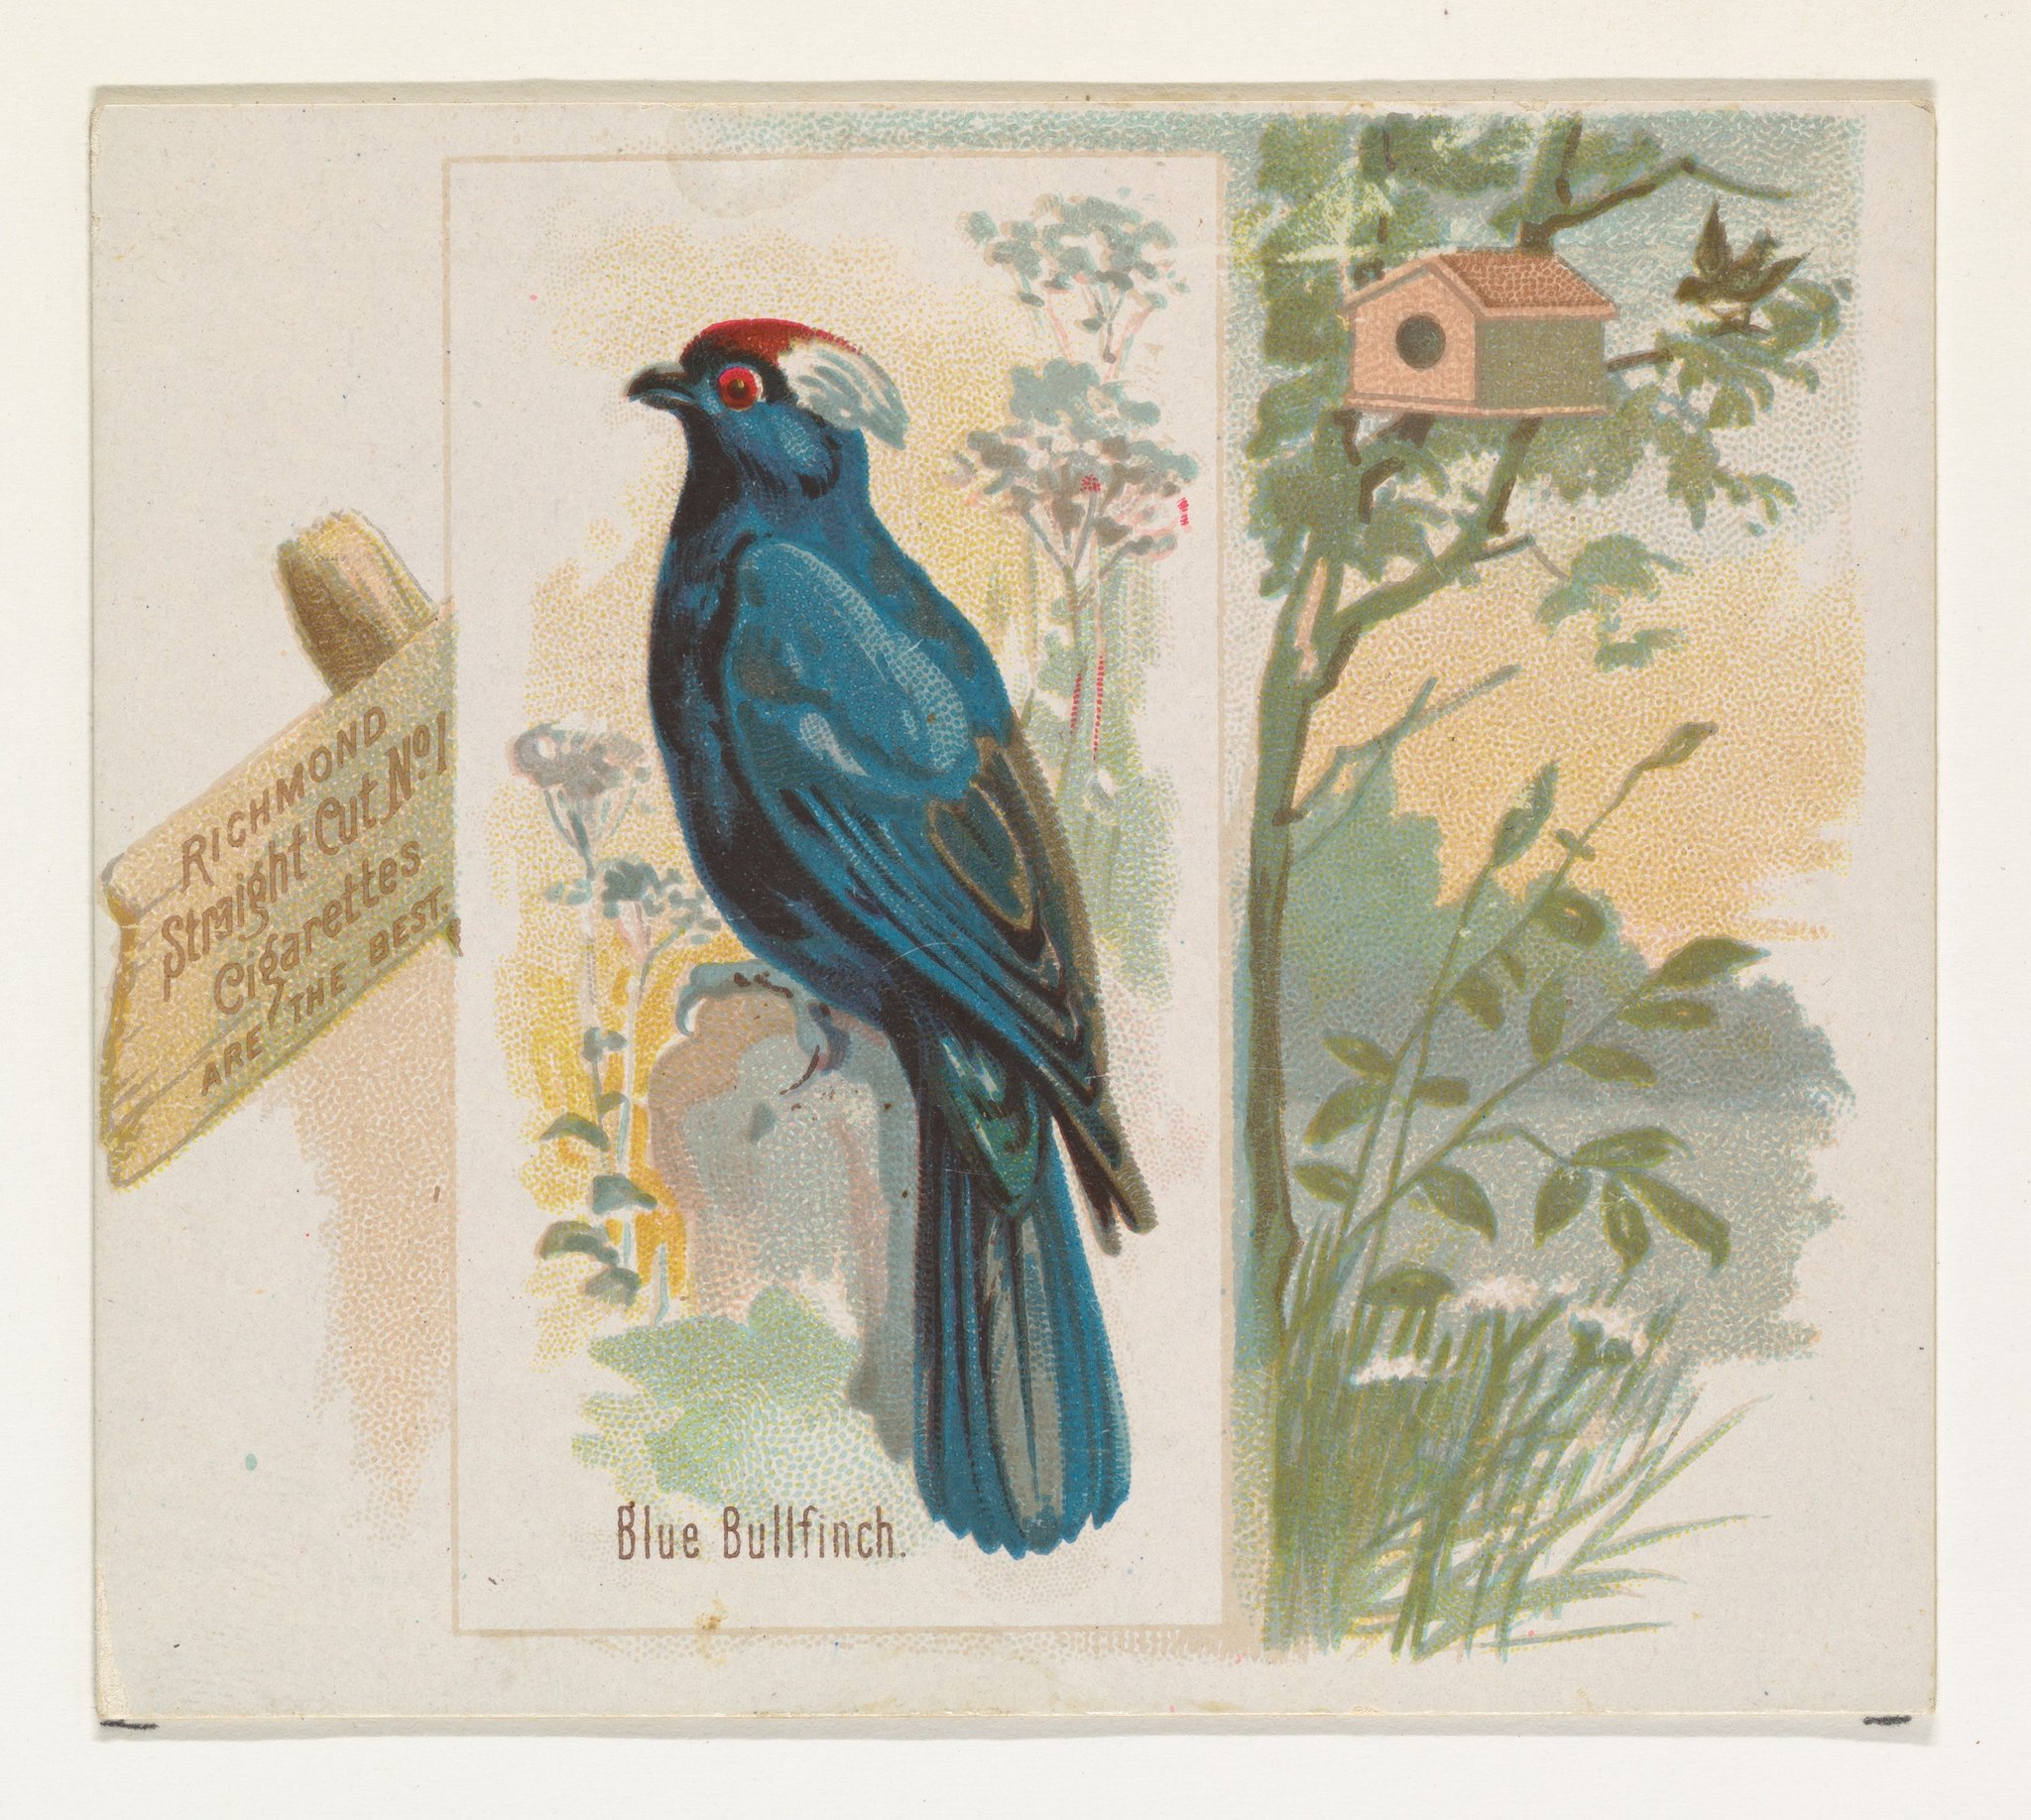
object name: print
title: Blue Bullfinch, from the Song Birds of the World series (N42) for Allen & Ginter Cigarettes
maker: allen & ginter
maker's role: publisher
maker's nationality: american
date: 1890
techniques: color lithograph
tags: birds